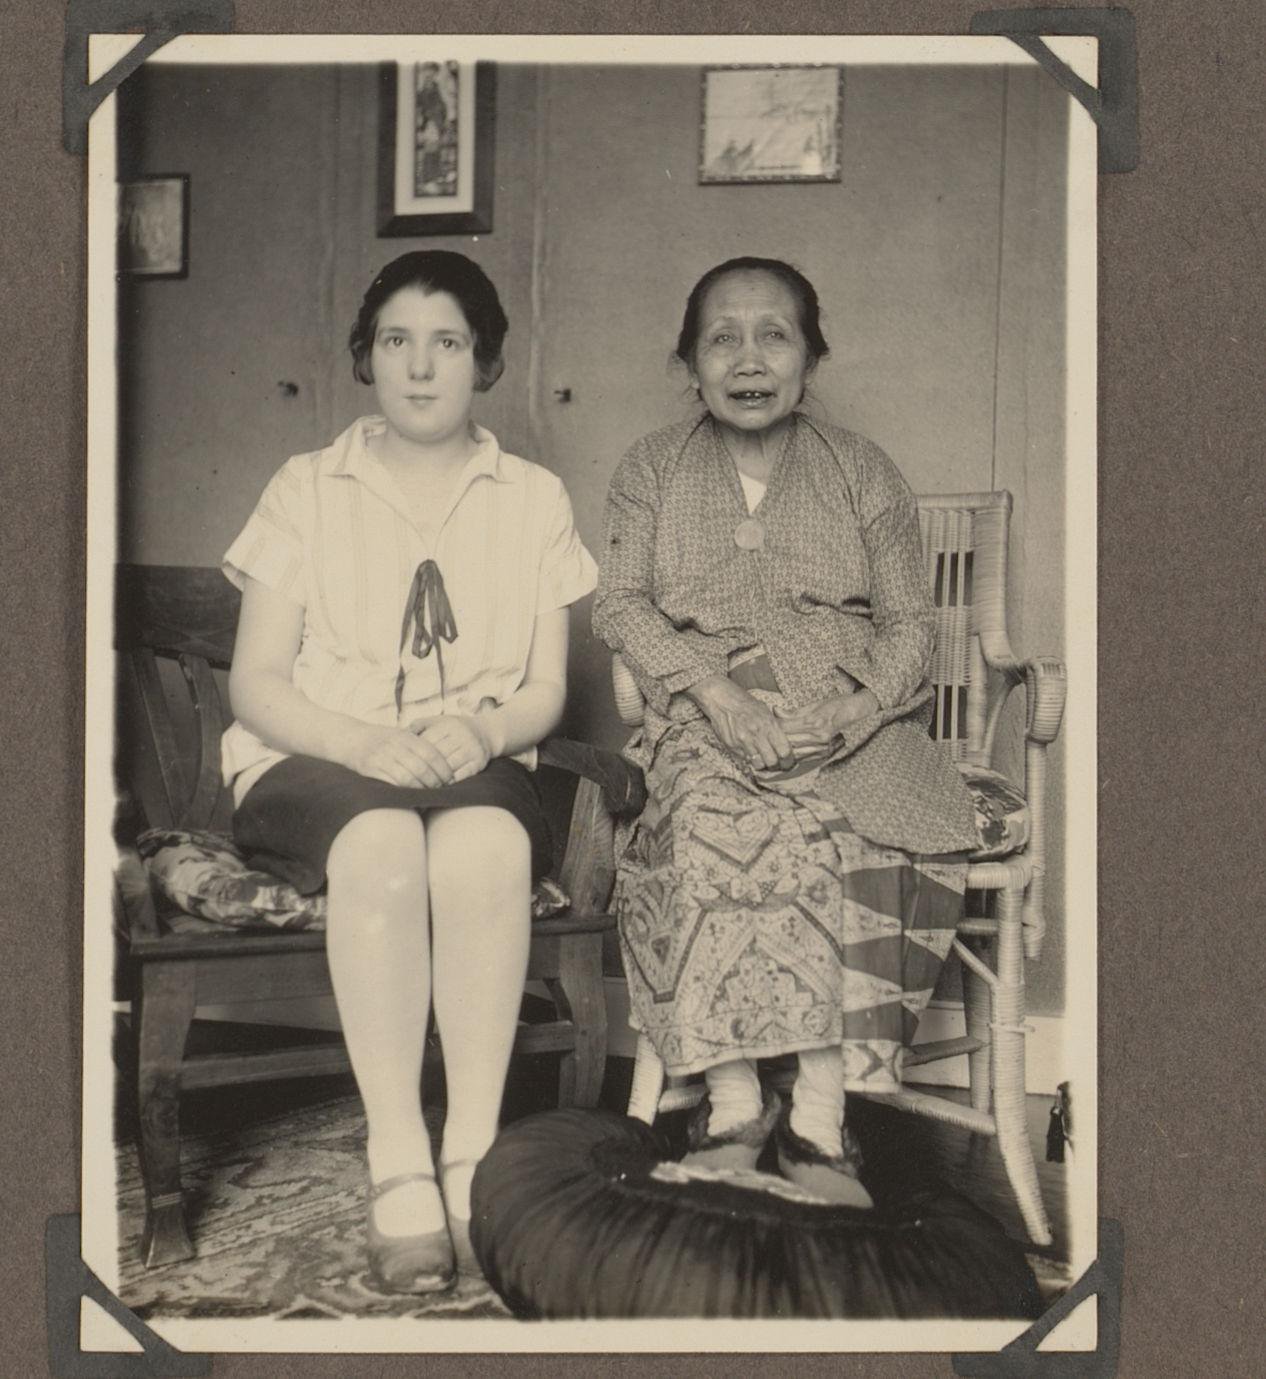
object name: album leaf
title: Portret van een jonge vrouw en kinderjuffrouw ('baboe') Lala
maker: Anonymous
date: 1930-1935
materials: paper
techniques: gelatin silver print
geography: netherlands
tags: baby-sitter, adolescent, young woman, maiden, historical persons, old woman, netherlands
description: Lala was een Indonesische kinderverzorgster (destijds 'baboe' genoemd). Deze foto maakt deel uit van een album.